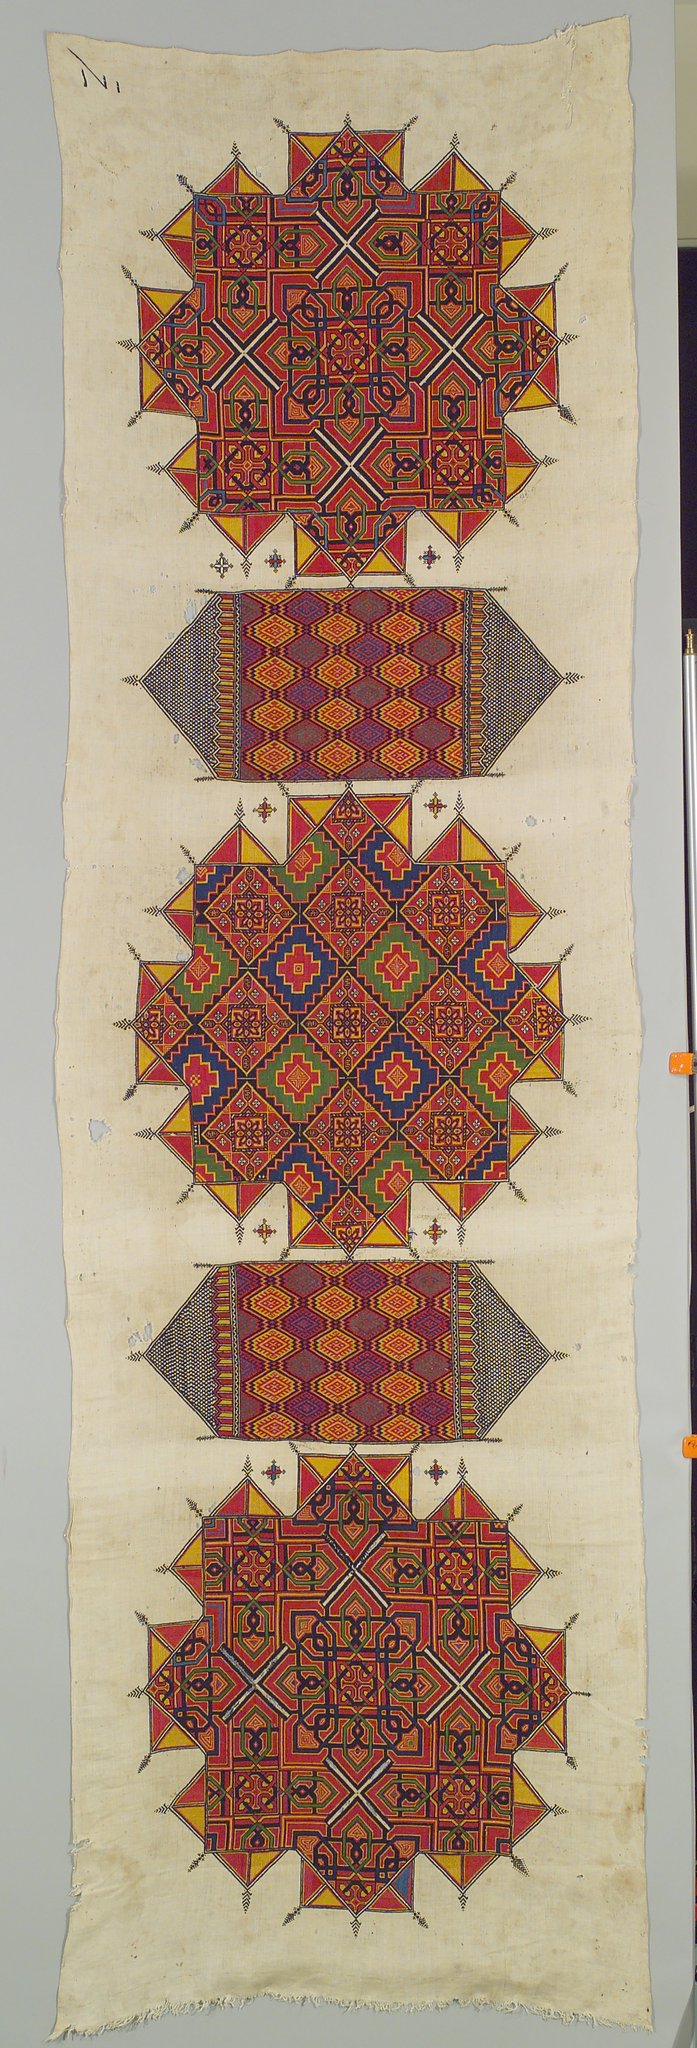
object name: hanging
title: Hanging (Arid)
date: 1800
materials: linen, silk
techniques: embroidery, weave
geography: morocco